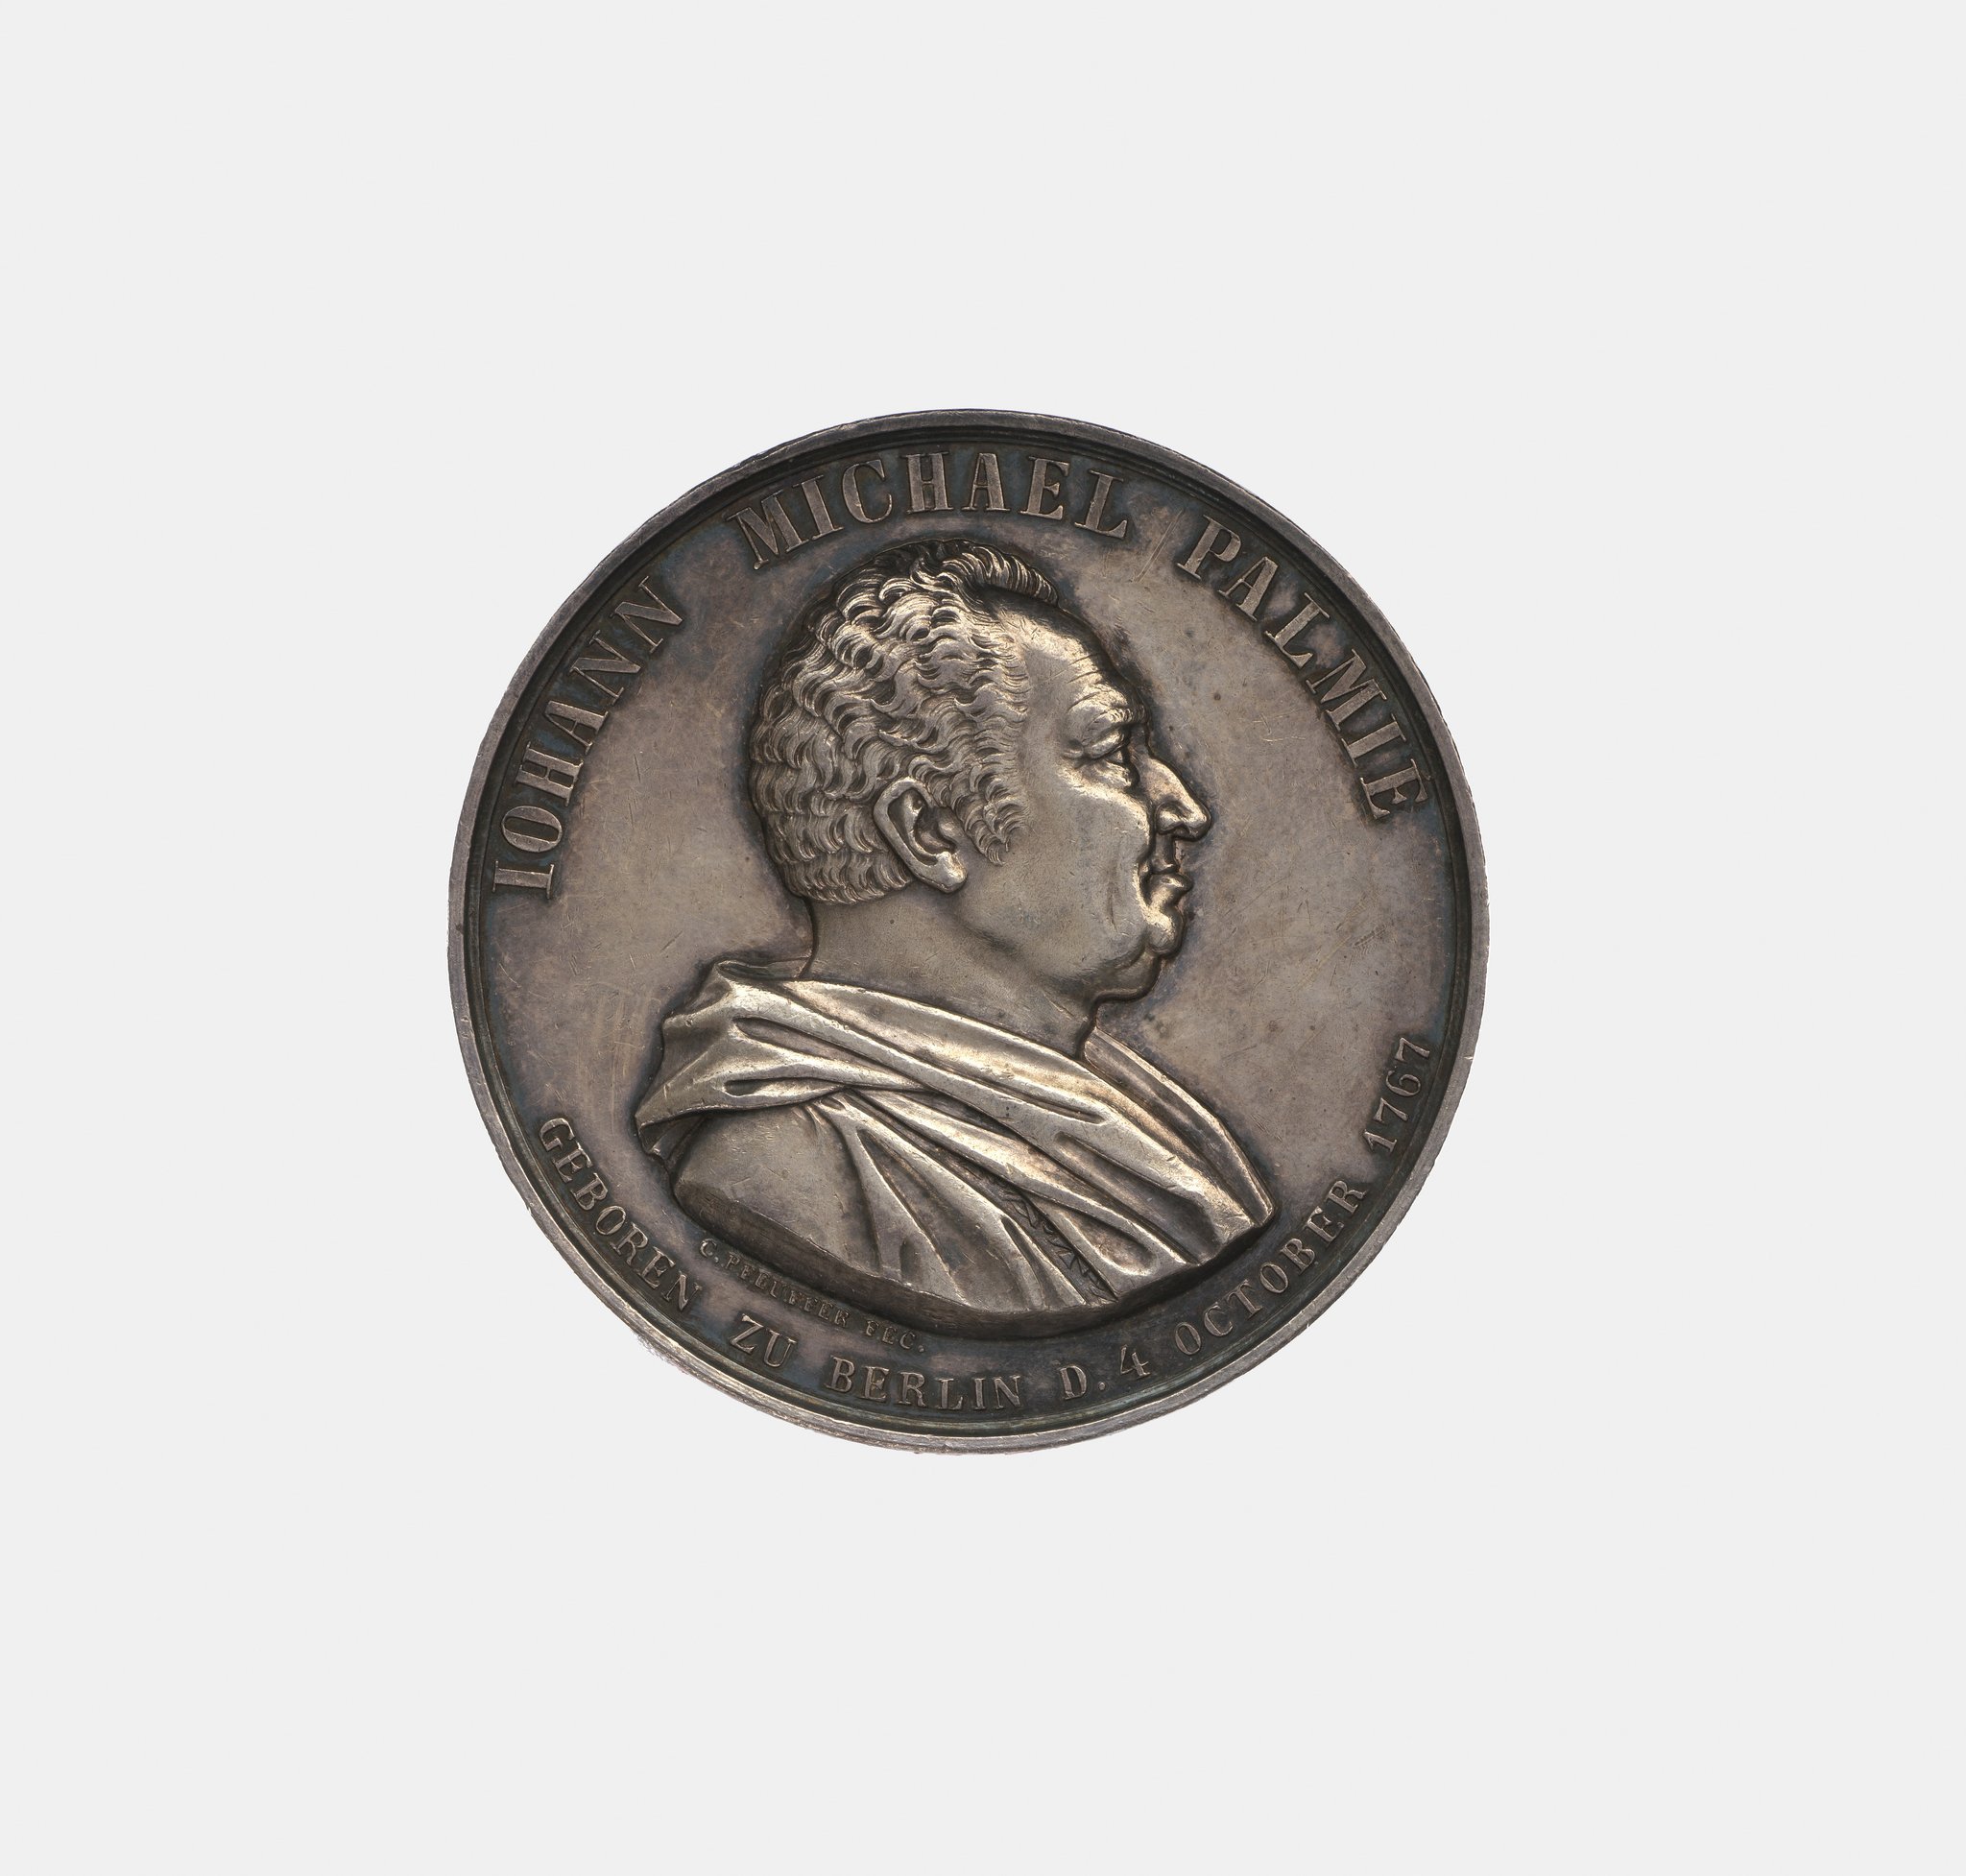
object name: medal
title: Johann Michael Palmie, Ordenmeister der “Grosse Landesloge von Deutschland” (Masonic Lodge)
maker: c. pfeuffer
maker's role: artist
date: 1840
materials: silver